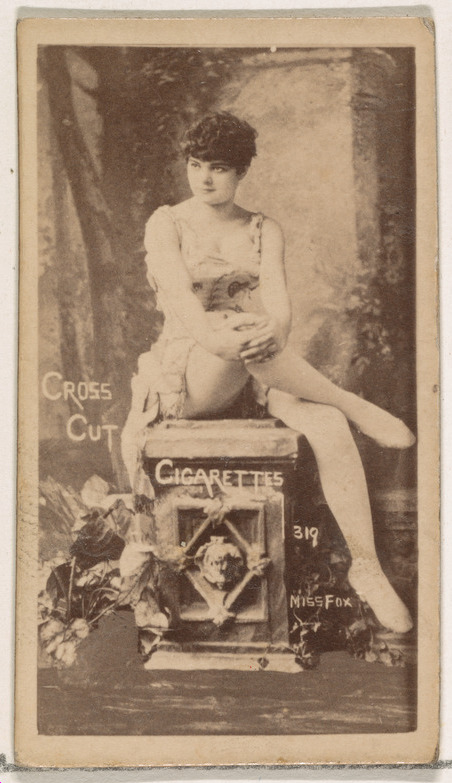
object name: print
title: Card Number 319, Miss Fox, from the Actors and Actresses series (N145-1) issued by Duke Sons & Co. to promote Cross Cut Cigarettes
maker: w. duke, sons & co.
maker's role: publisher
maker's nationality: american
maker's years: 1870-1920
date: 1880-1889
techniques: albumen silver print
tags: portraits,women,actresses